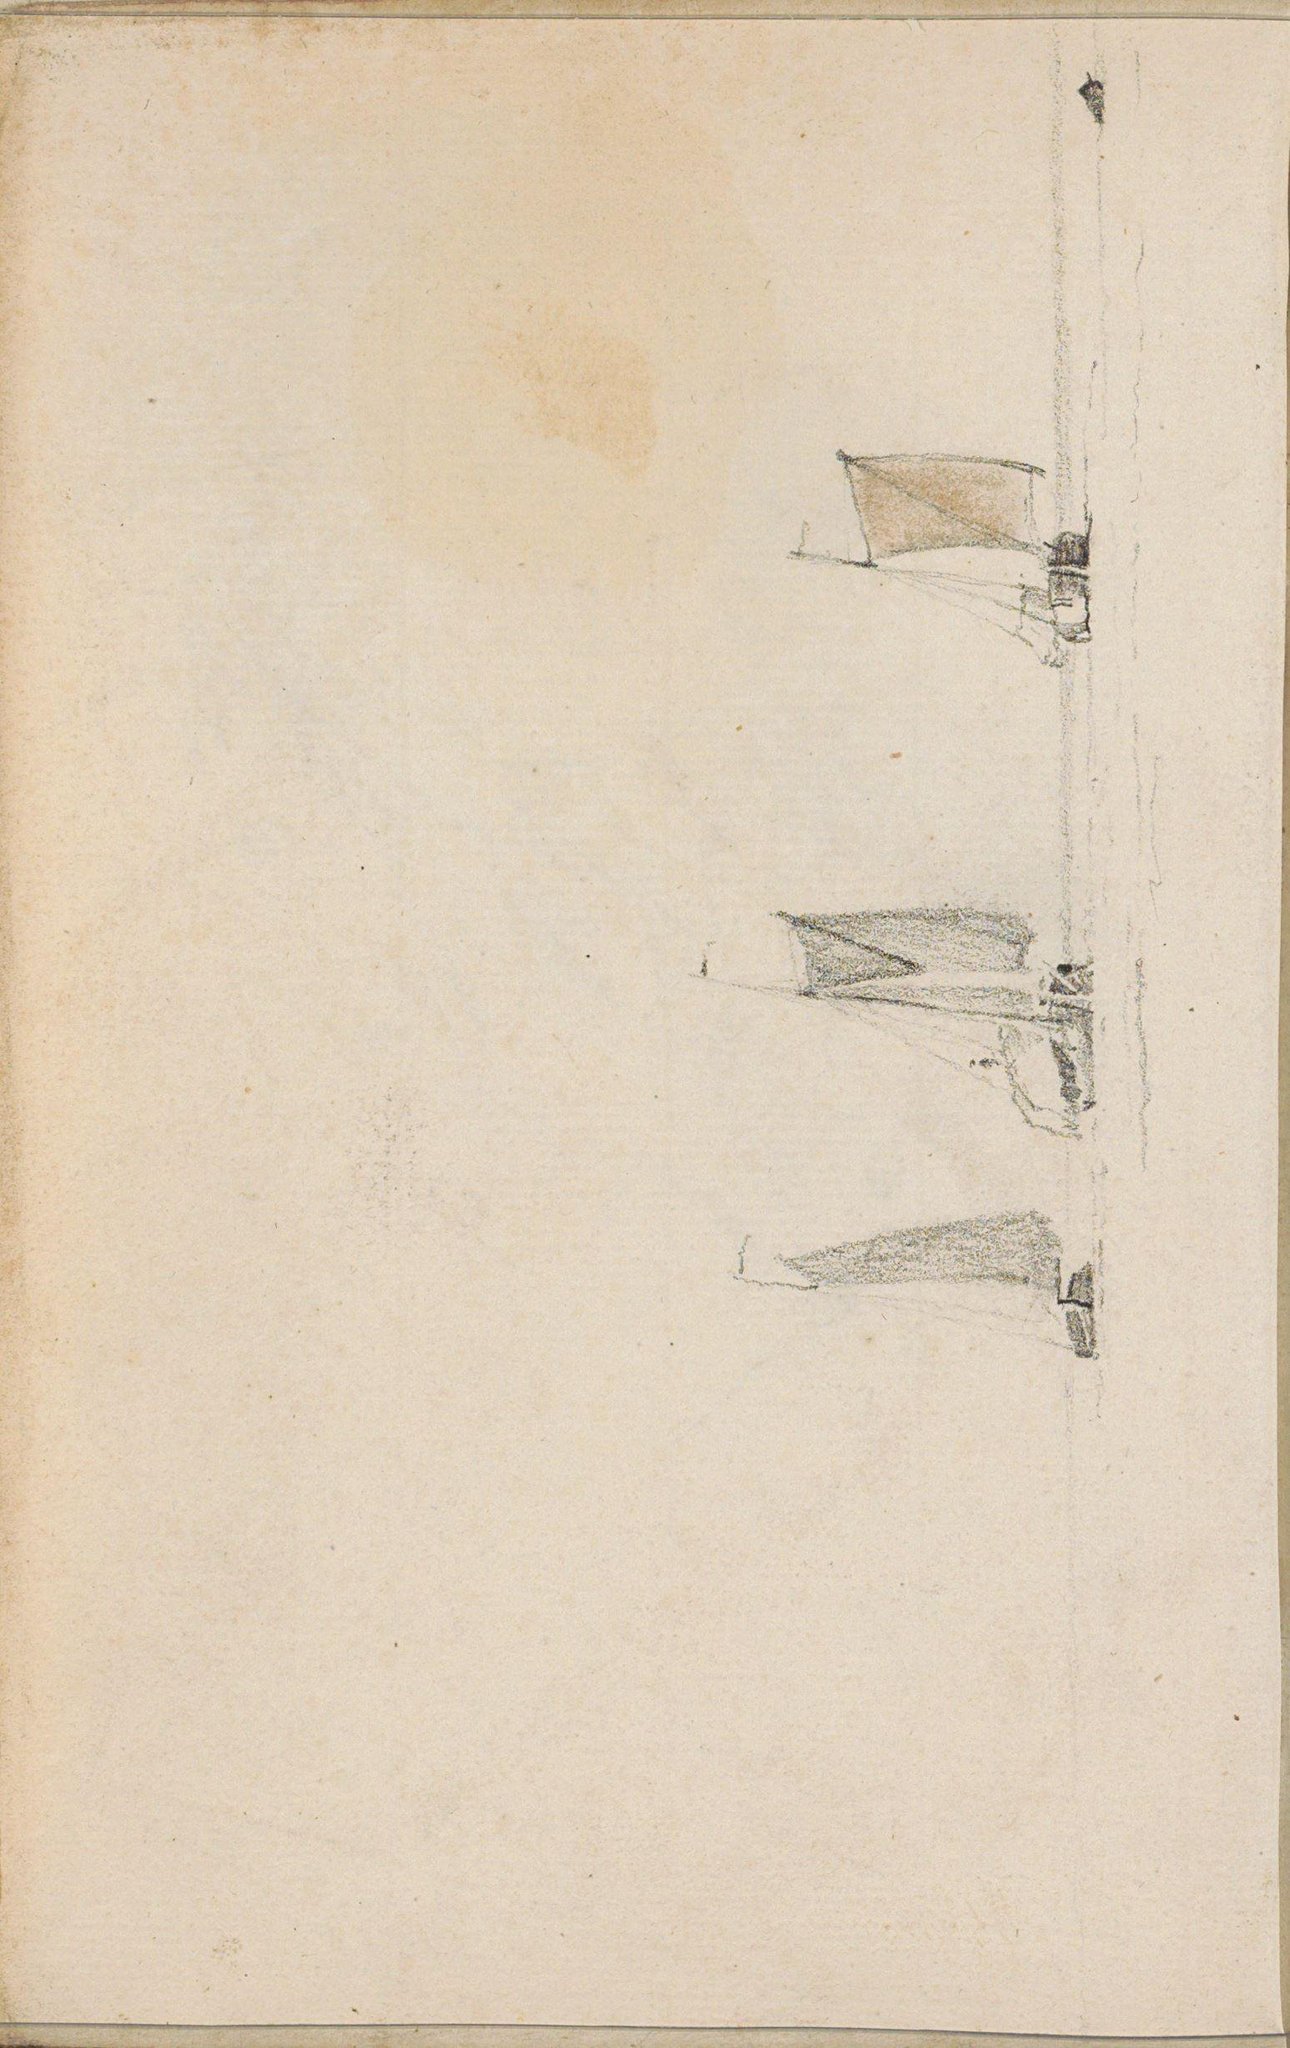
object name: sketchbook leaf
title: Drie zeilschepen op open water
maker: jacob perkois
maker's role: draughtsman, print maker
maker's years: 1756-1804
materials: chalk, paper, pencil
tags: sailing-ship, sailing-boat, landscapes with waters, waterscapes, seascapes (in the temperate zone)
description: Bladzijde 14 uit een schetsboek met 78 bladzijden.